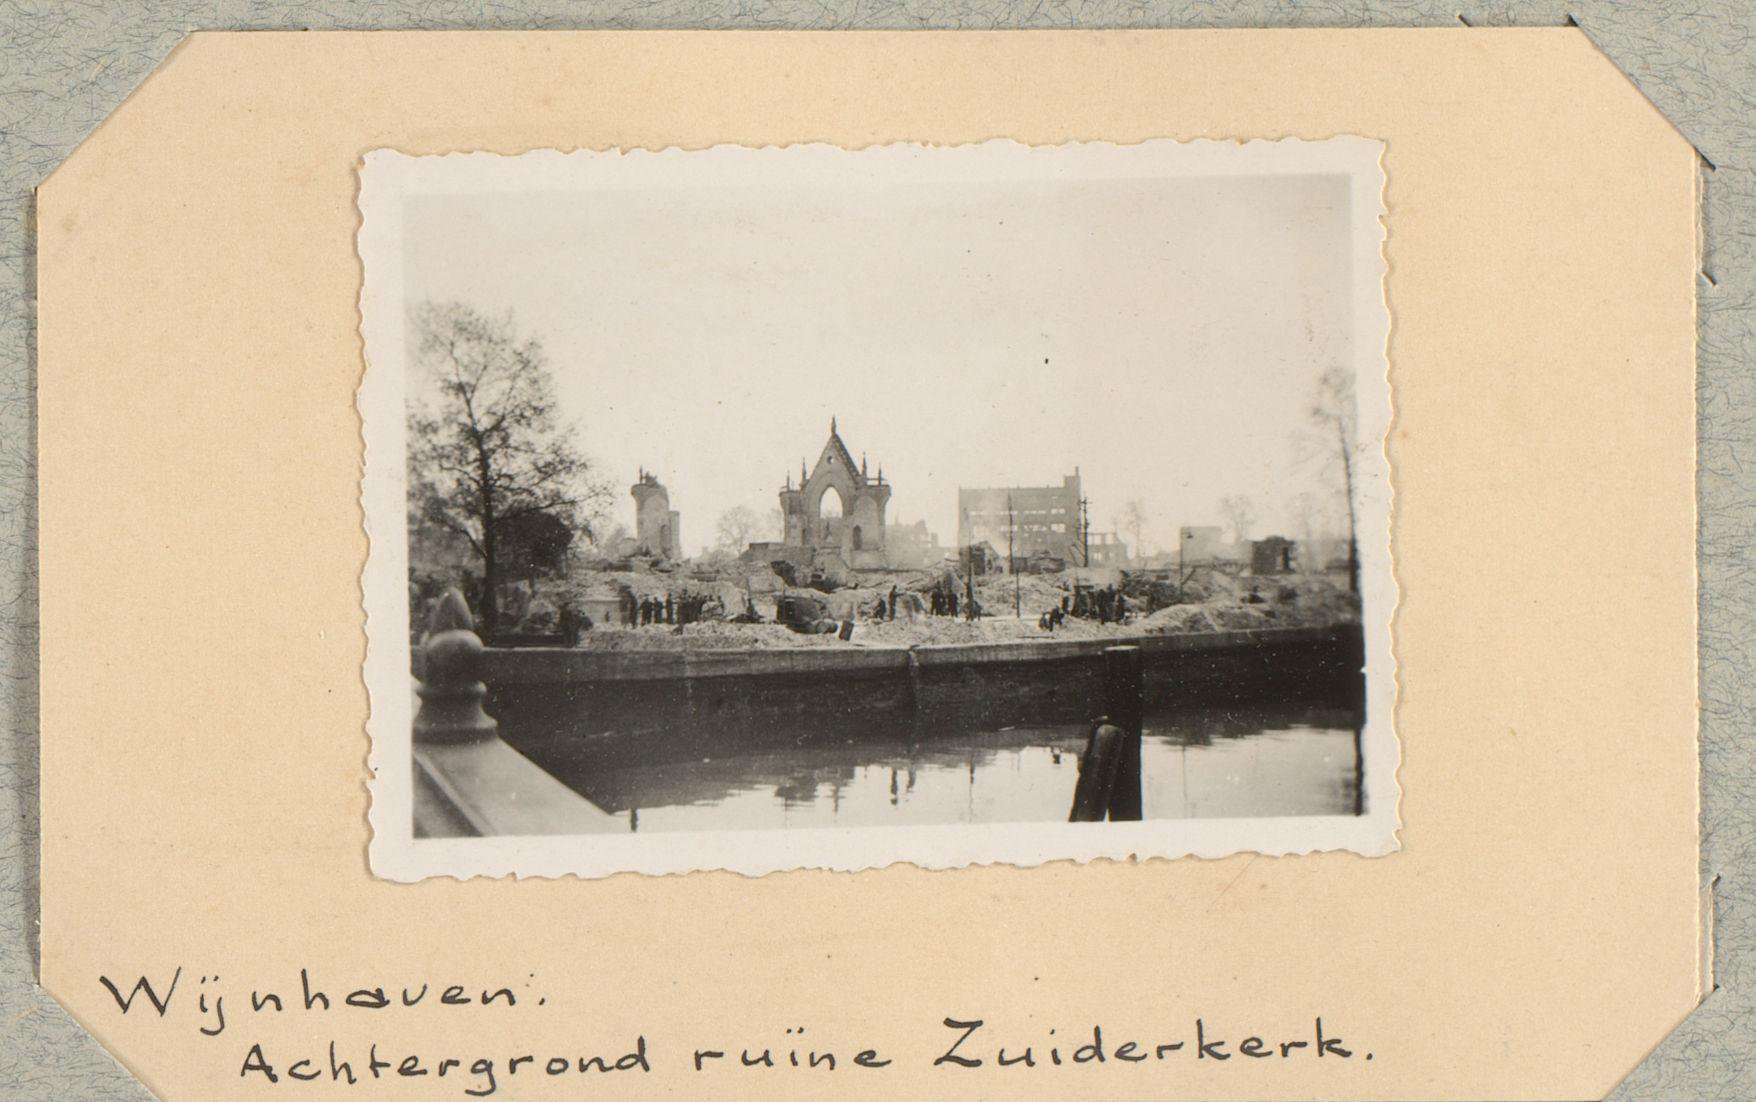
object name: photograph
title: Ruïnes van de Zuiderkerk en de Wijnhaven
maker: j. nolte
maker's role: fotograaf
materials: photographic support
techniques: gelatin silver print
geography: rotterdam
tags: ruin of church, monastery, etc. - qq - small church, chapel, devastated, ruined place or city (~ warfare), ruin of a dwelling, house, castle, etc., rotterdam, rotterdam blitz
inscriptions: annotation: ‘Wijnhaven,/ Achtergrond ruïne Zuiderkerk.’